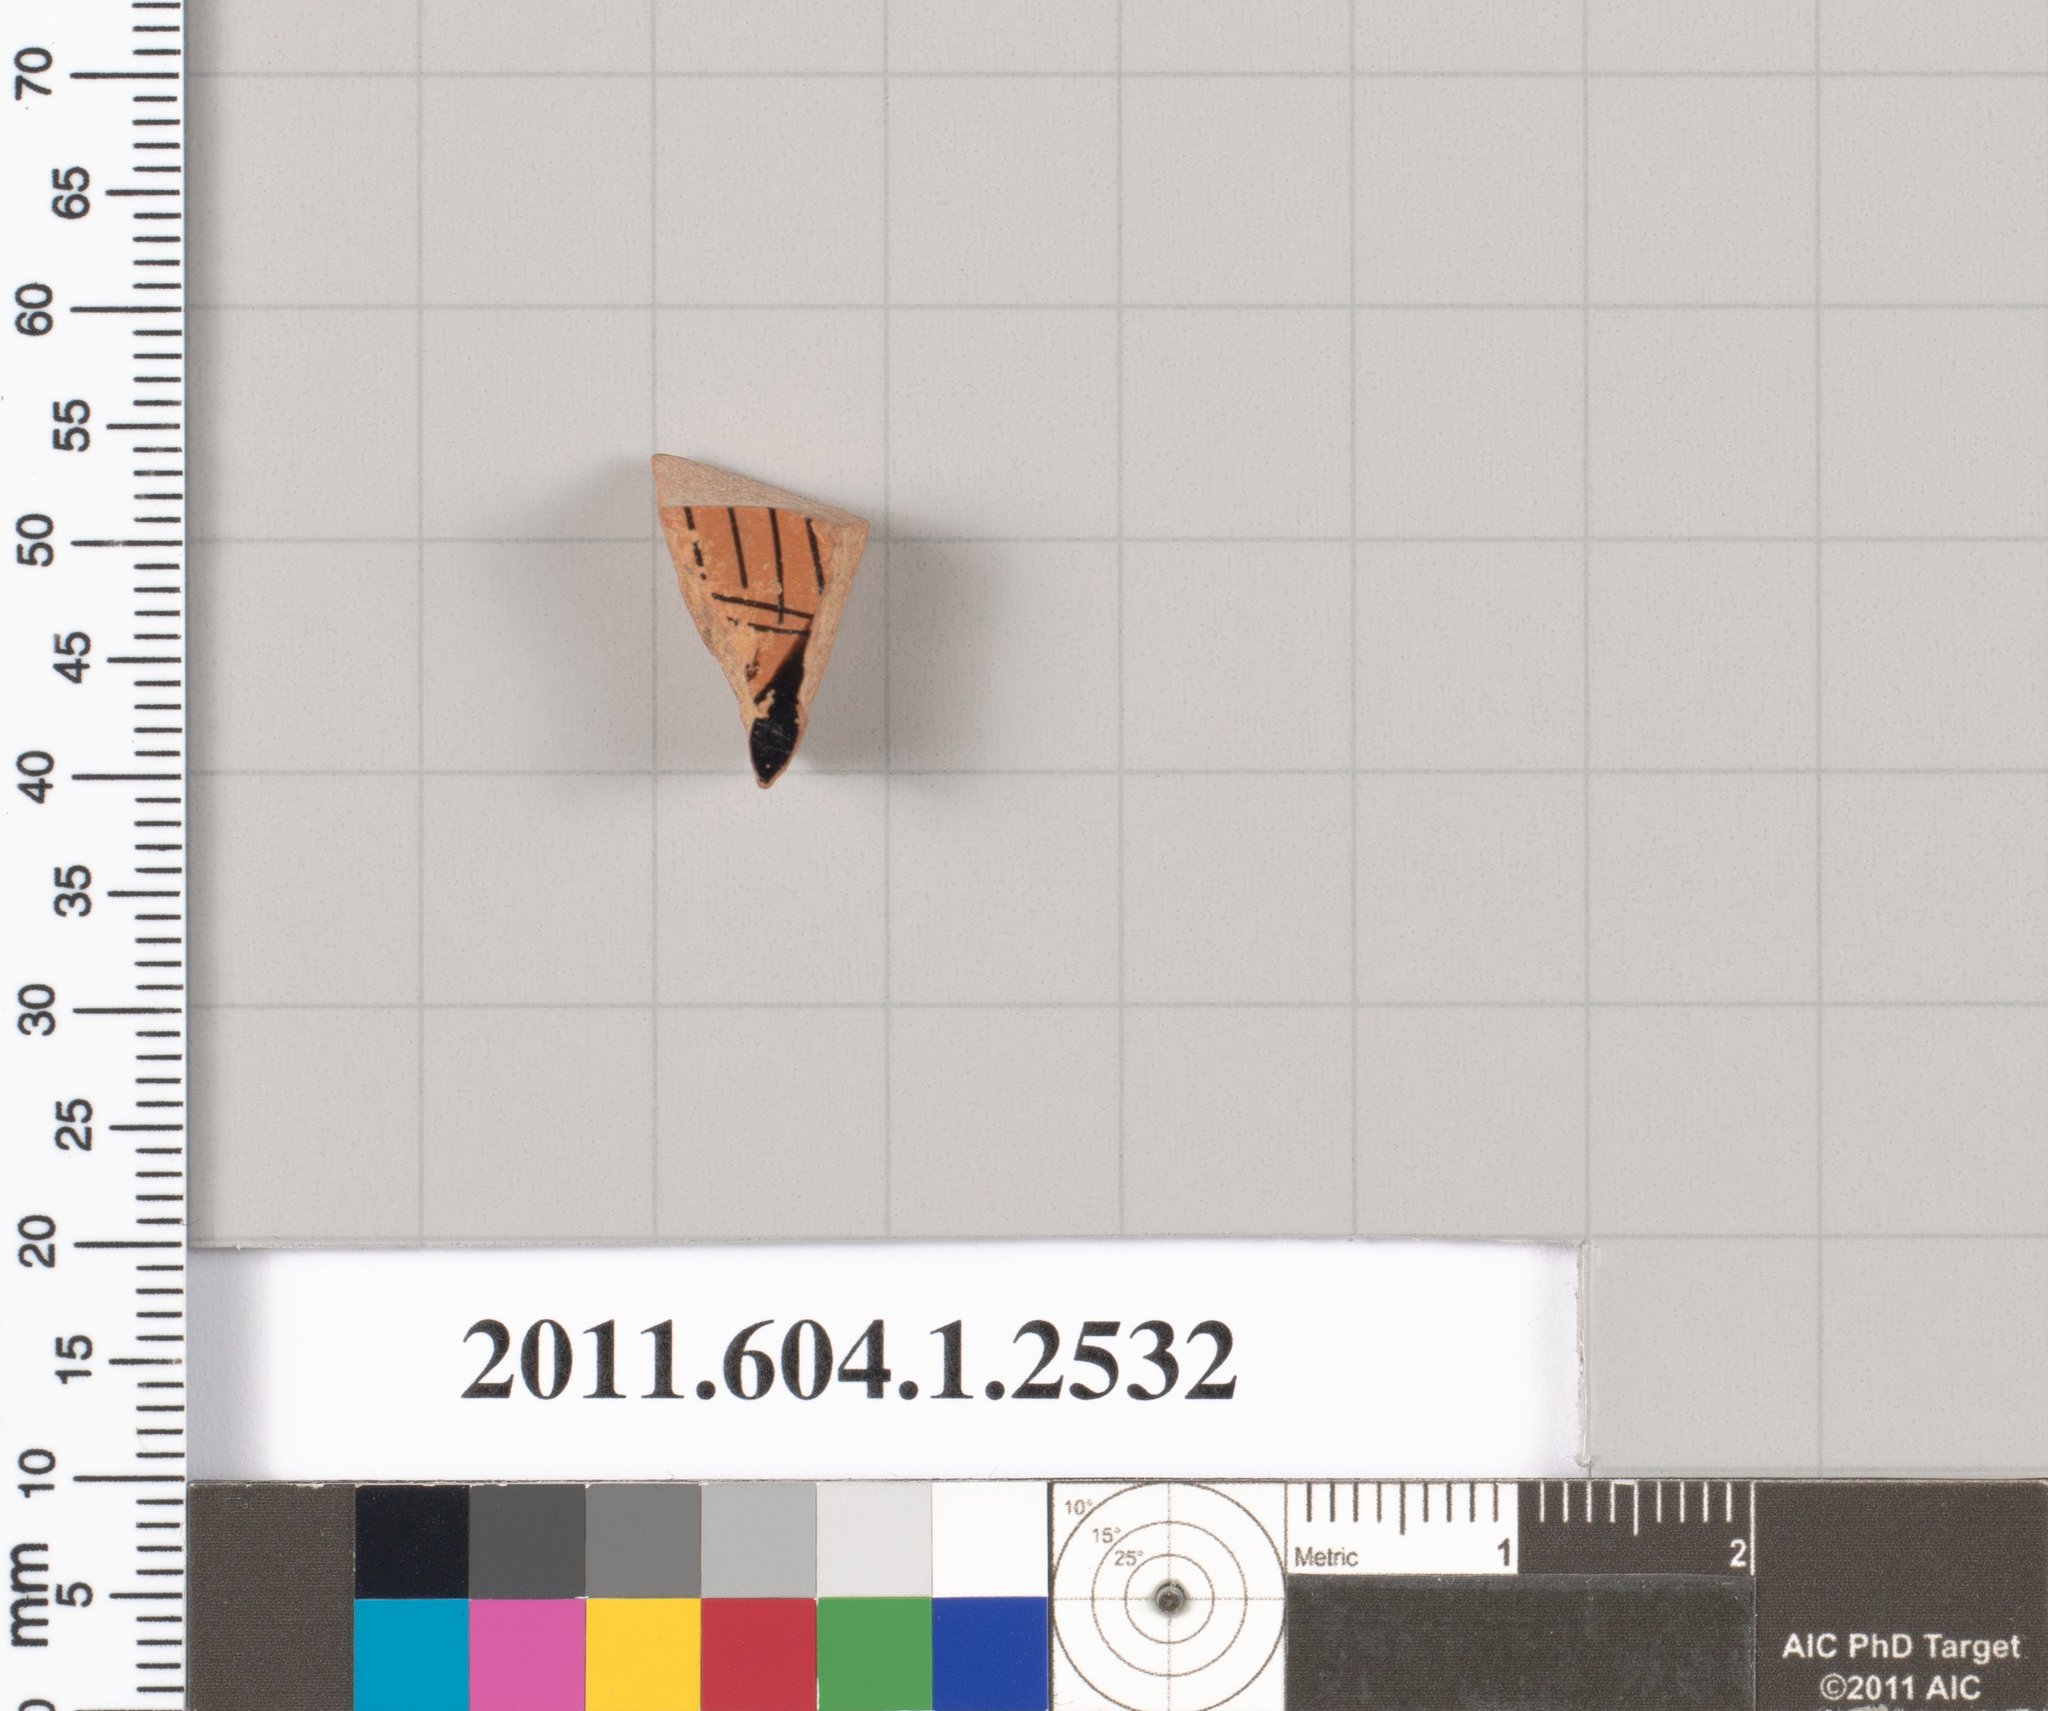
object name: kylix fragment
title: Terracotta fragment of a kylix (drinking cup)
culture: greek, attic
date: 475-451 BCE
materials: terracotta